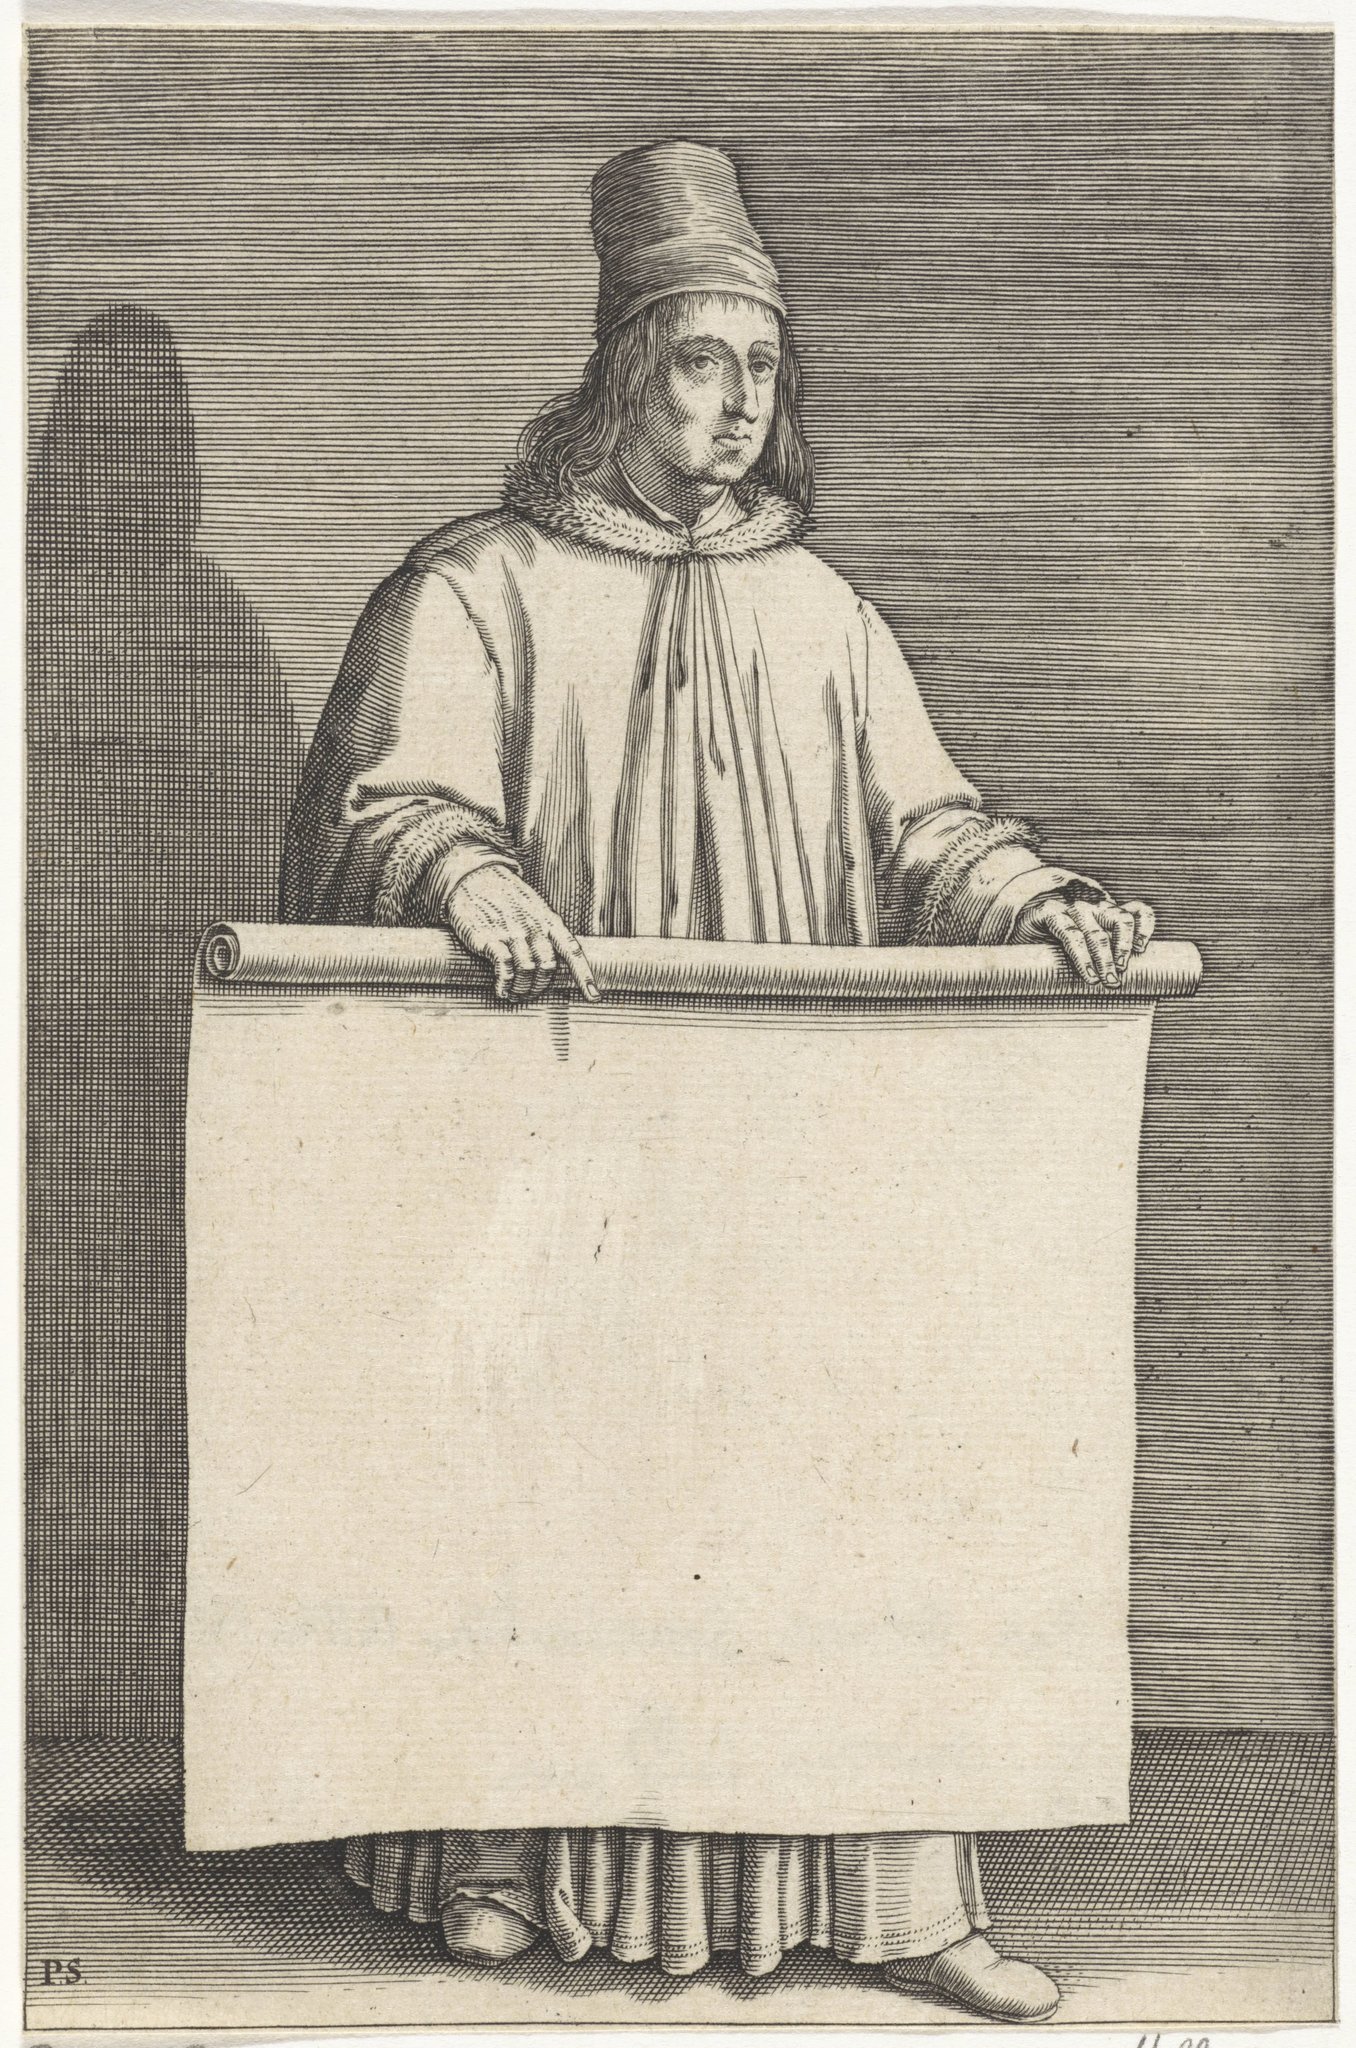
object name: print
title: Jongeman met een rol papier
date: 1601-1657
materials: paper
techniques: engraving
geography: amsterdam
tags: scroll - ll - scroll unfolded, youth, adolescent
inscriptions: collector's mark: ‘M’, collector's mark: Lugt 2228, inscription: ‘Par Pierre Serwouter 158601657 qui était bien édité par ClaeszJansz Visser’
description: Jongeman met een uitgerolde boekrol in de hand. Hij wijst met zijn vinger op het onbeschreven schrijfvlak.